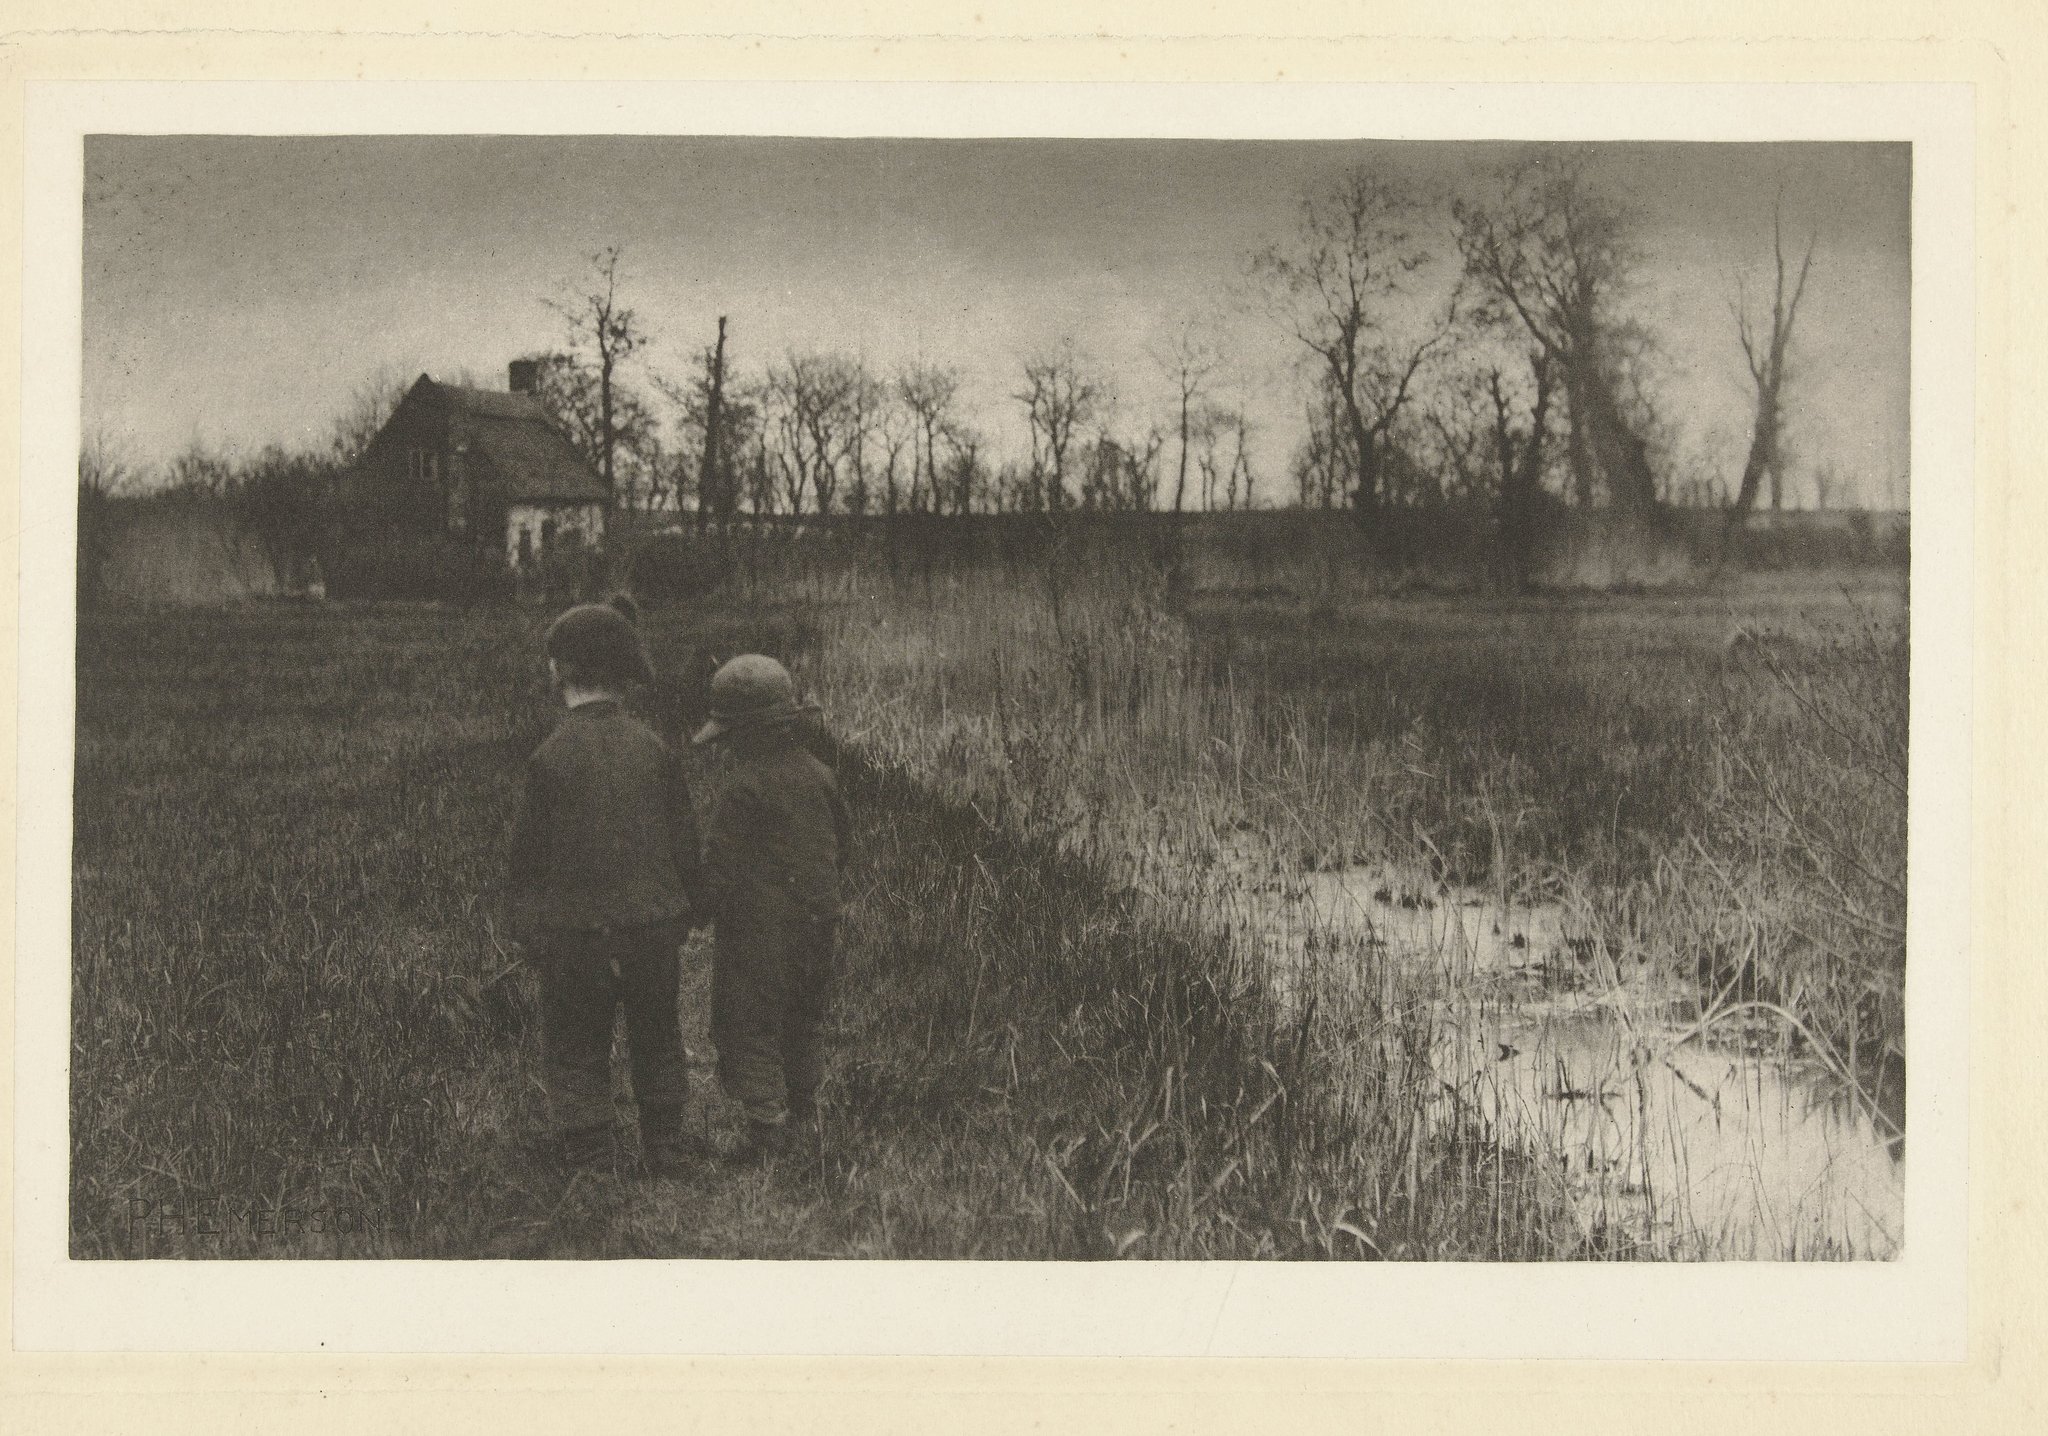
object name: photomechanical print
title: A Toad in the Path - Early Spring in Norfolk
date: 1883-1888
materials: cardboard, paper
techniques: photoaquatint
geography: great britain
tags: toddler